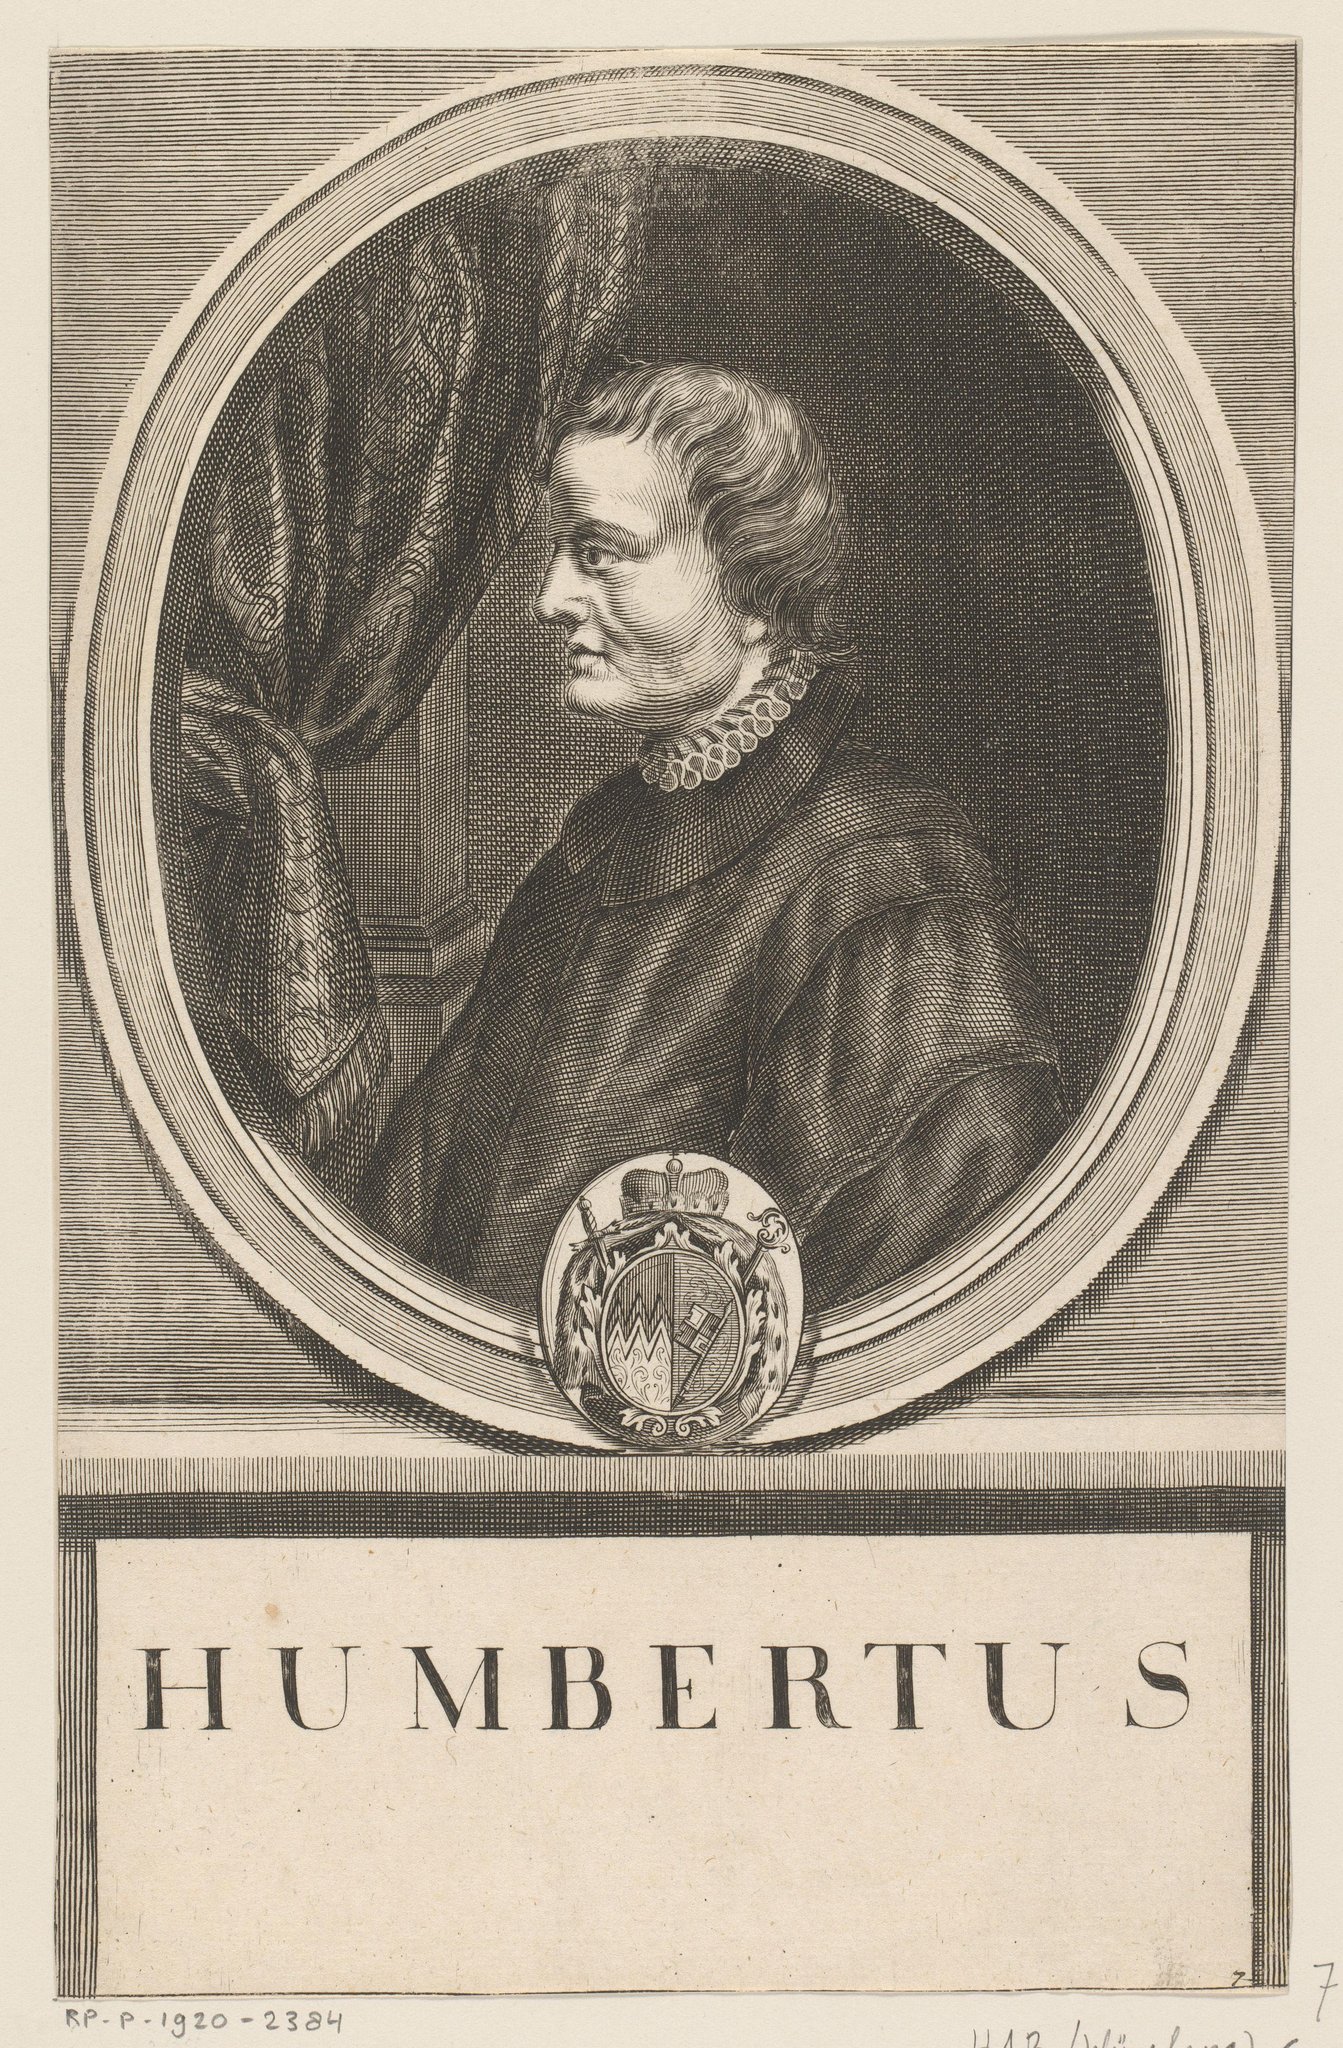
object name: print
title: Humbertus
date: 1713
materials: paper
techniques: engraving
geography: frankfurt am main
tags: archbishop, bishop, etc. (roman catholic), historical persons, armorial bearing, heraldry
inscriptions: collector's mark: Lugt 2228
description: Prent uit: Ludewig, Johann Peter von. Geschicht-Schreiber von dem Bischoffthum Wirtzburg (...). Frankfurt am Main: Thomas Fritsch, 1713.